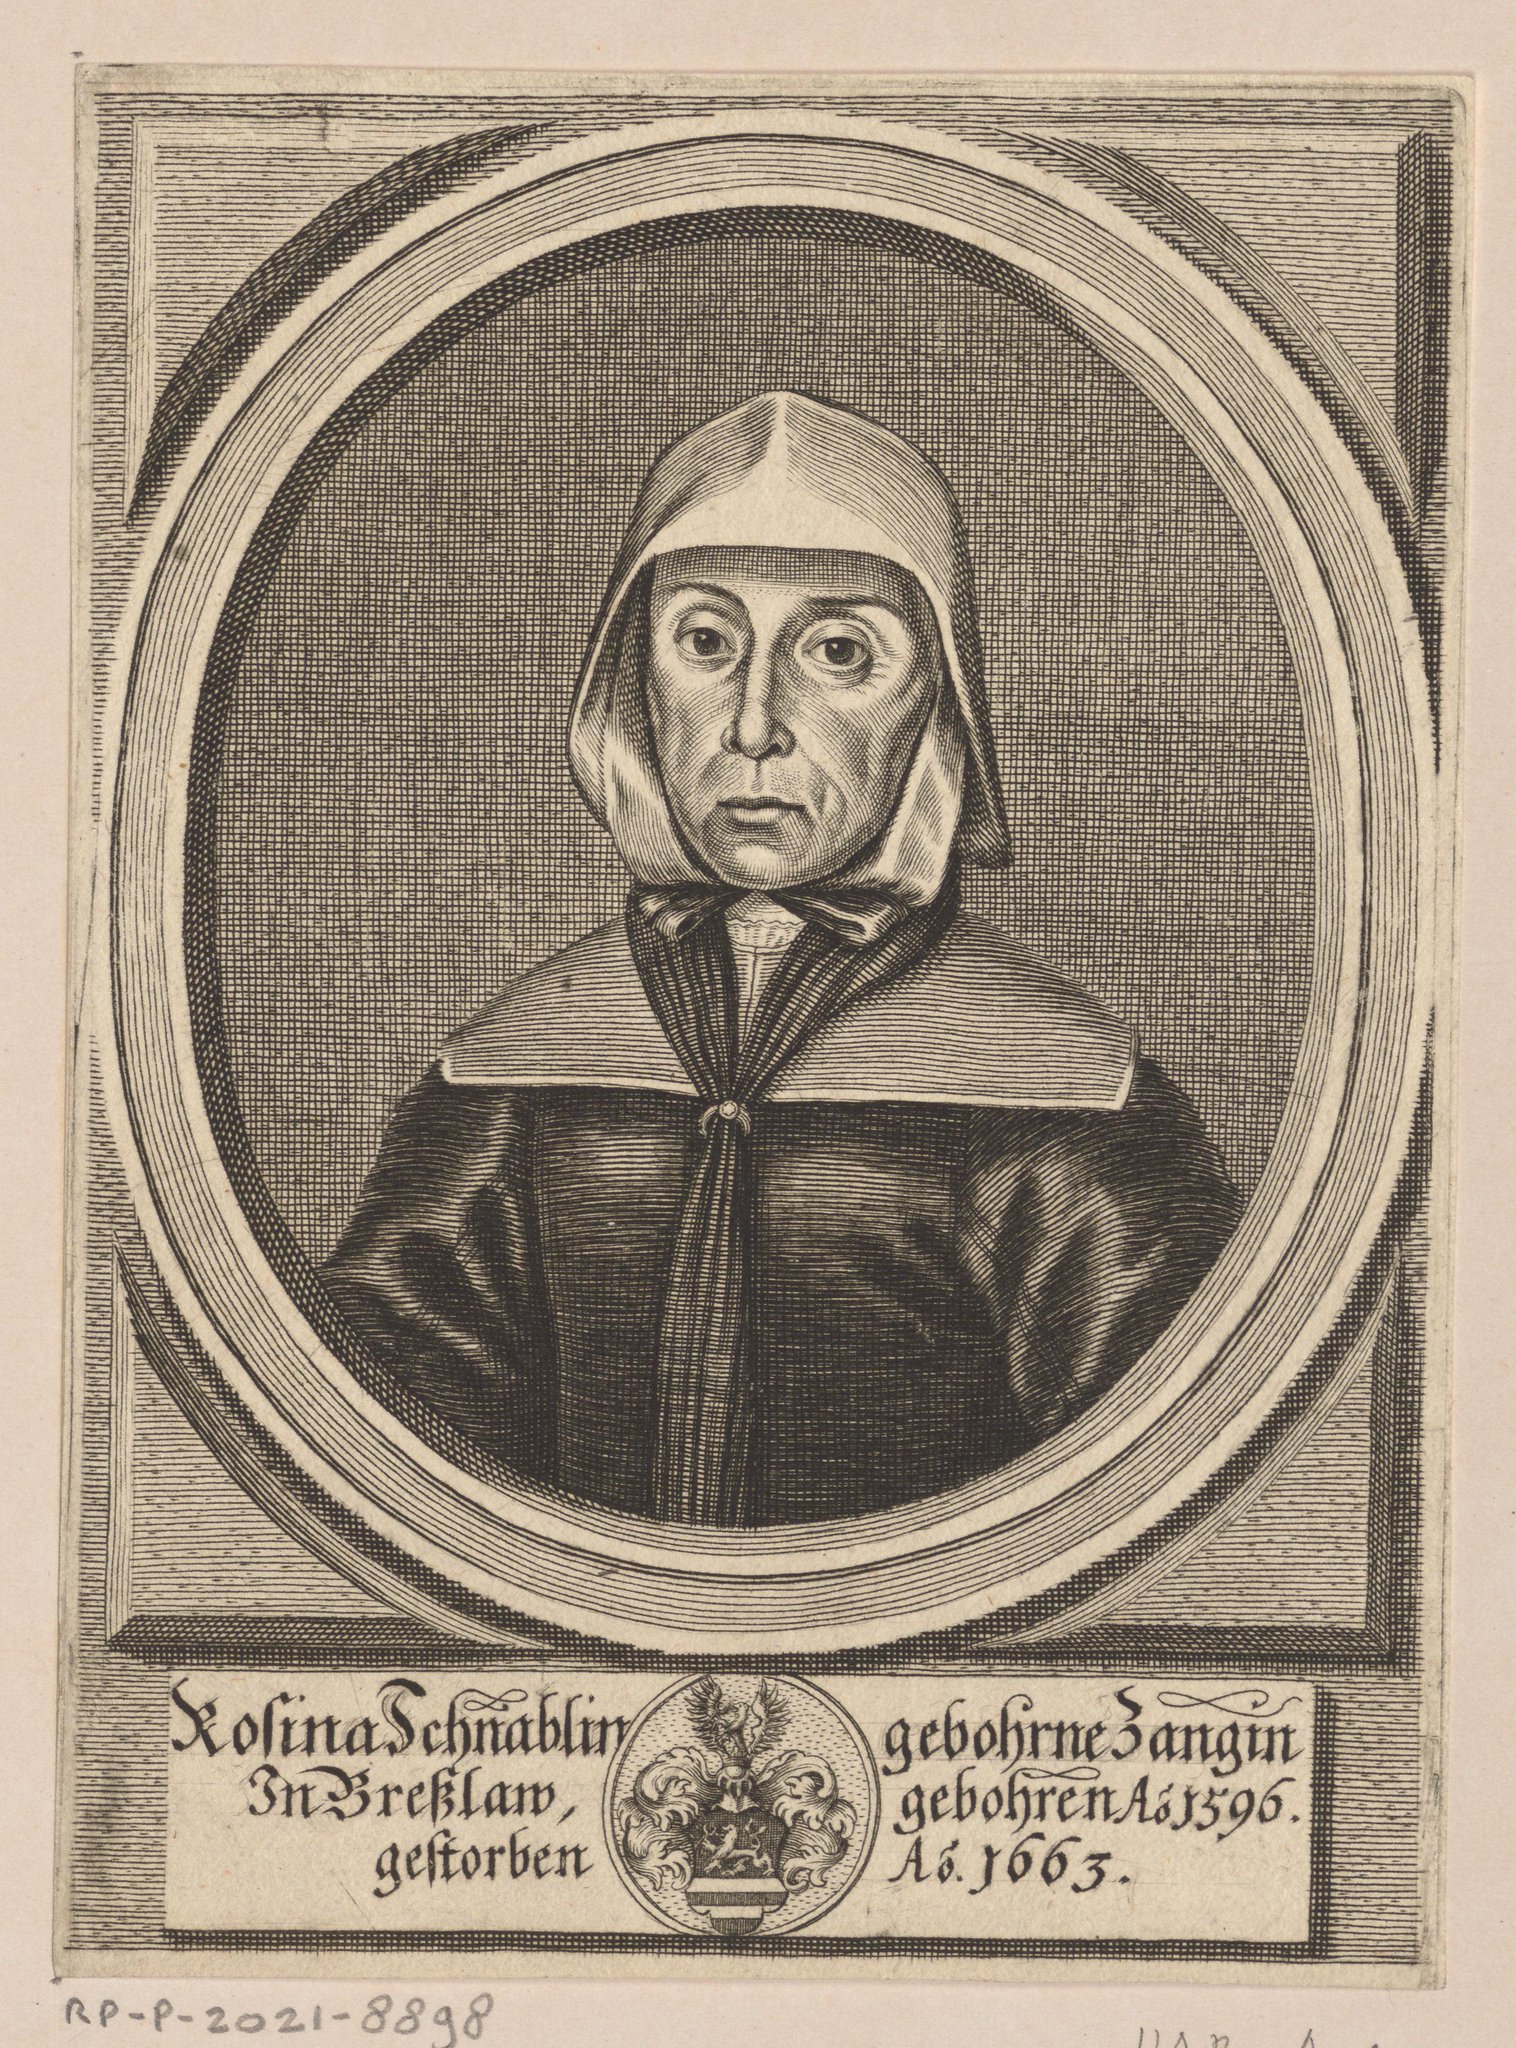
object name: print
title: Portret van Rosina Schnablin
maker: Anonymous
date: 1663-1699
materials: paper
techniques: engraving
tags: head-gear, historical persons - bb - woman